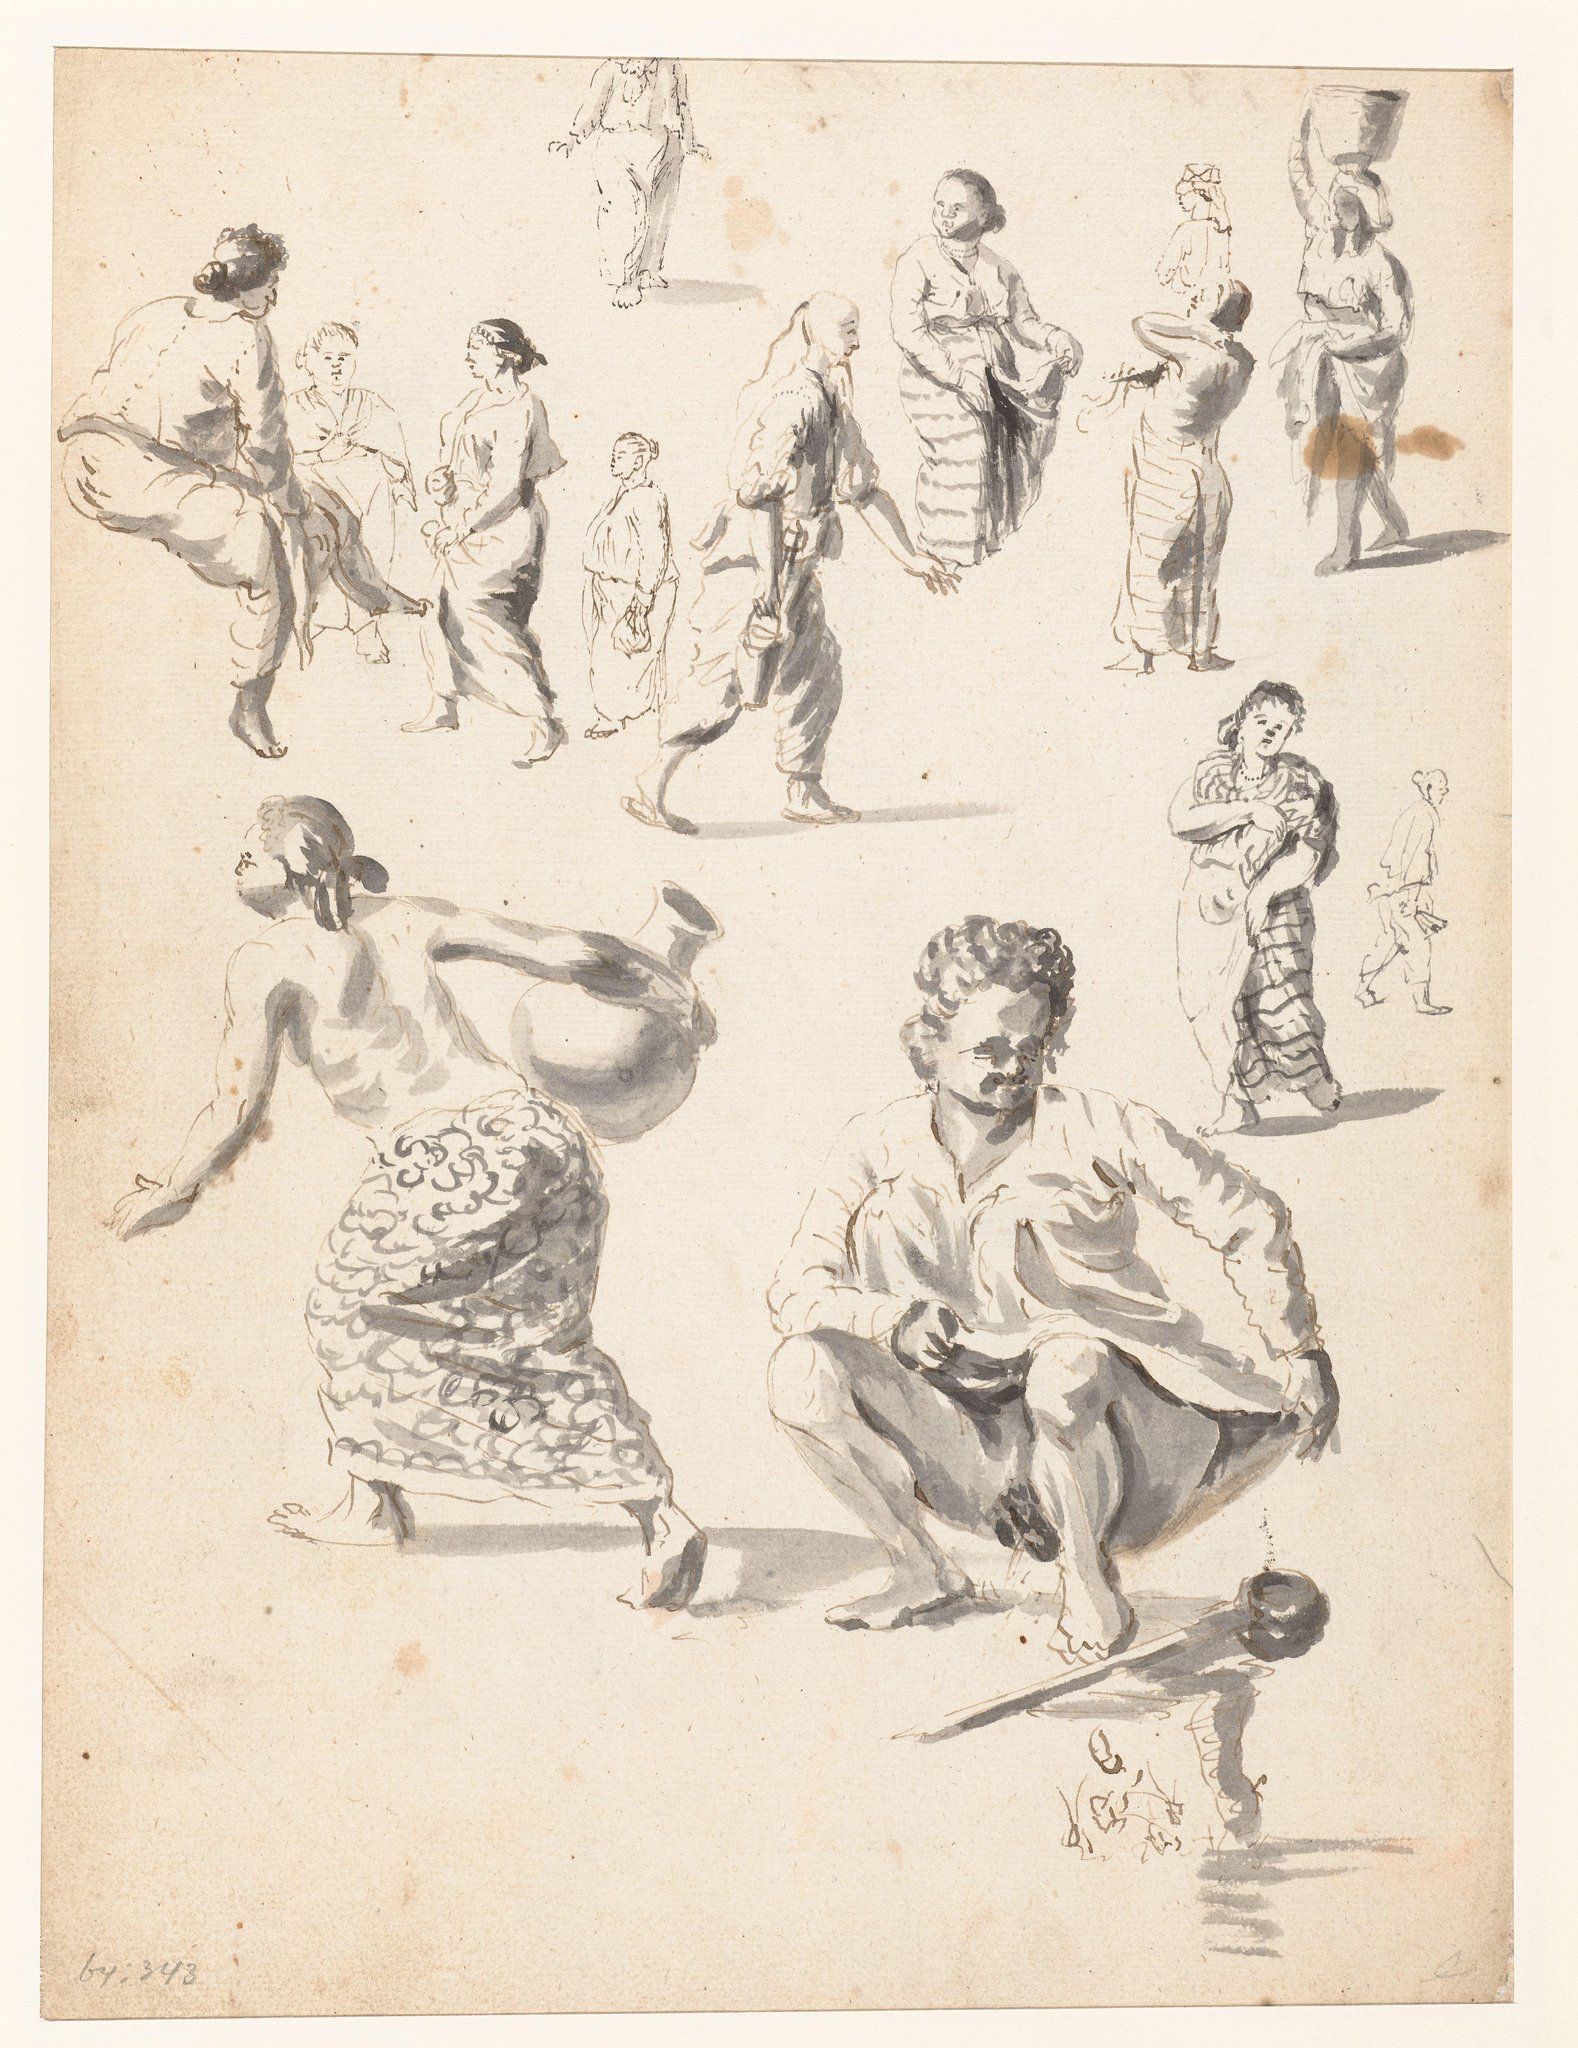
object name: drawing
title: Reisschetsen gemaakt in Indië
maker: wouter schouten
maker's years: 1638-1704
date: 1660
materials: ink, paper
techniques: brush, pen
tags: batavia